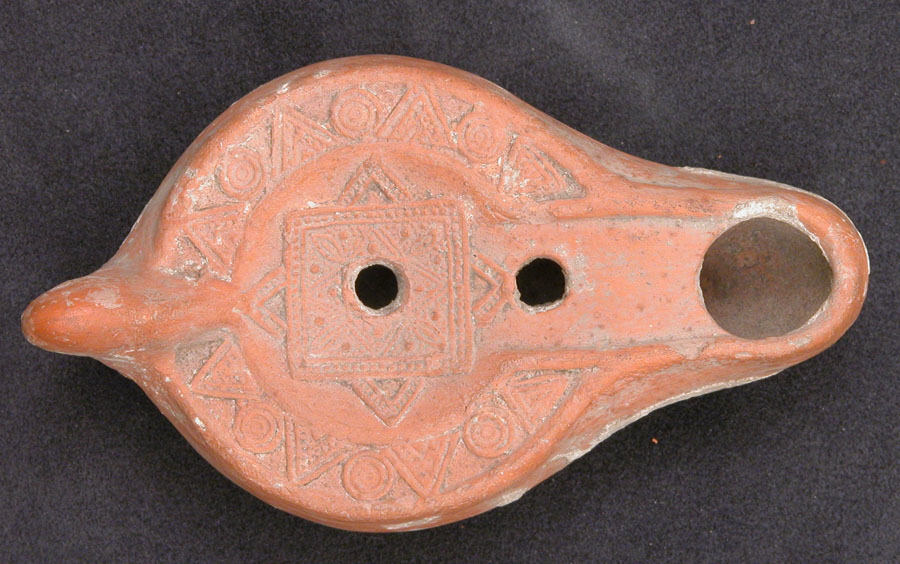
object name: lamp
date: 401-600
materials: earthenware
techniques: molding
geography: egypt